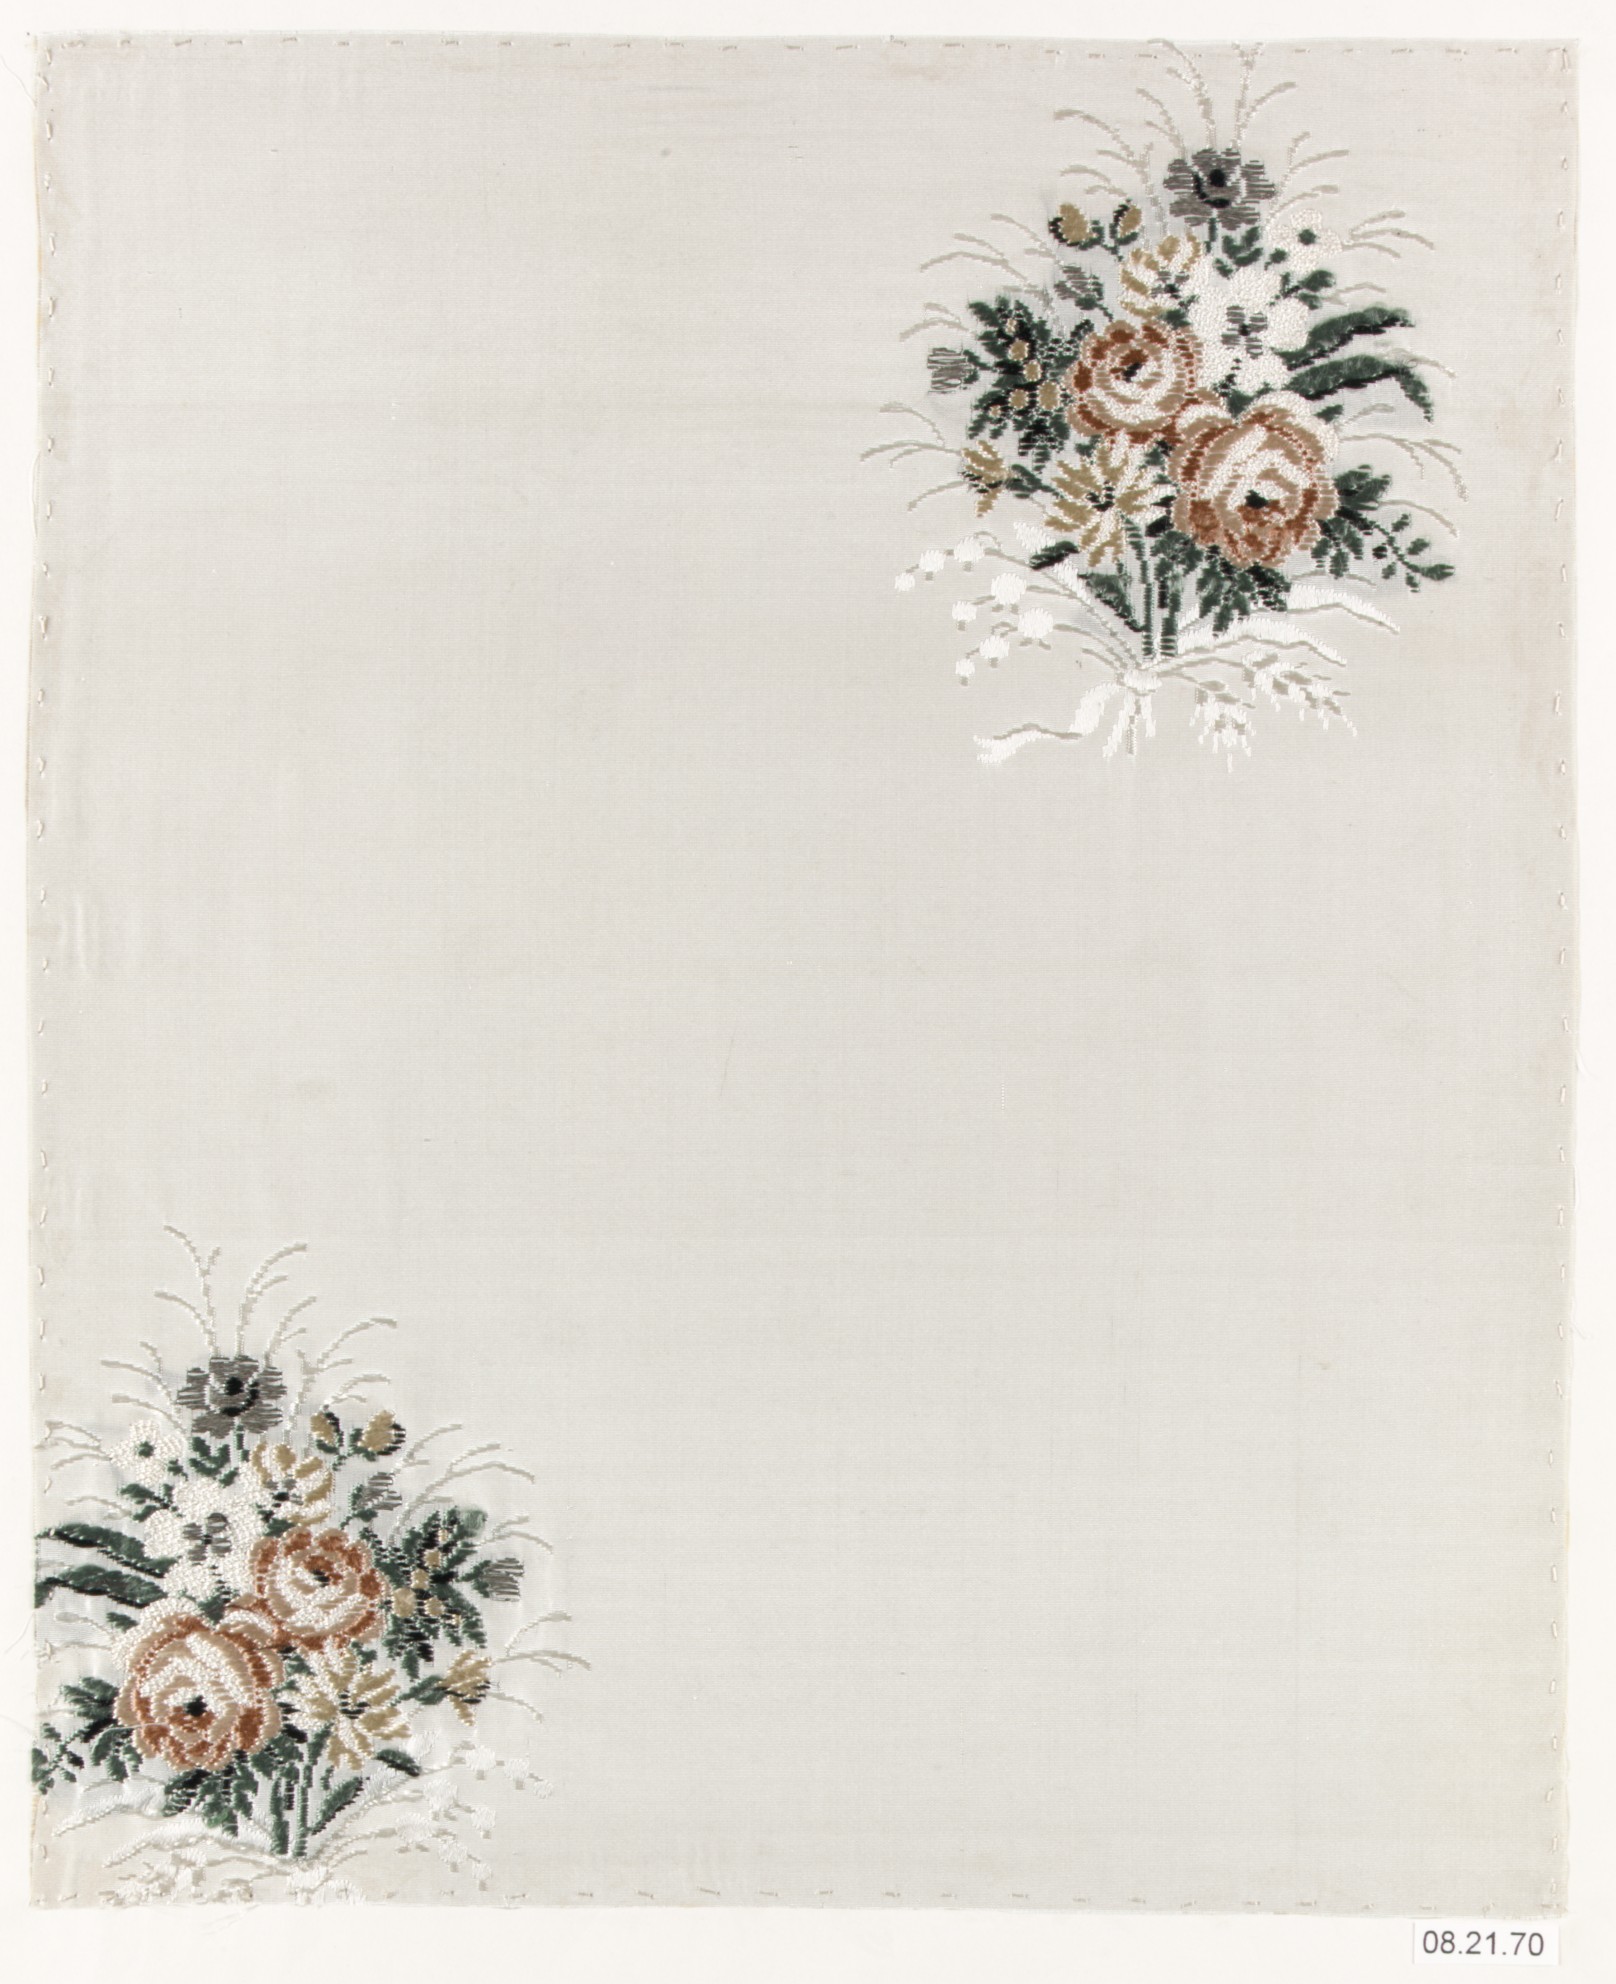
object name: textile sample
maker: Anonymous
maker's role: designer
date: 1900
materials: silk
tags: flowers